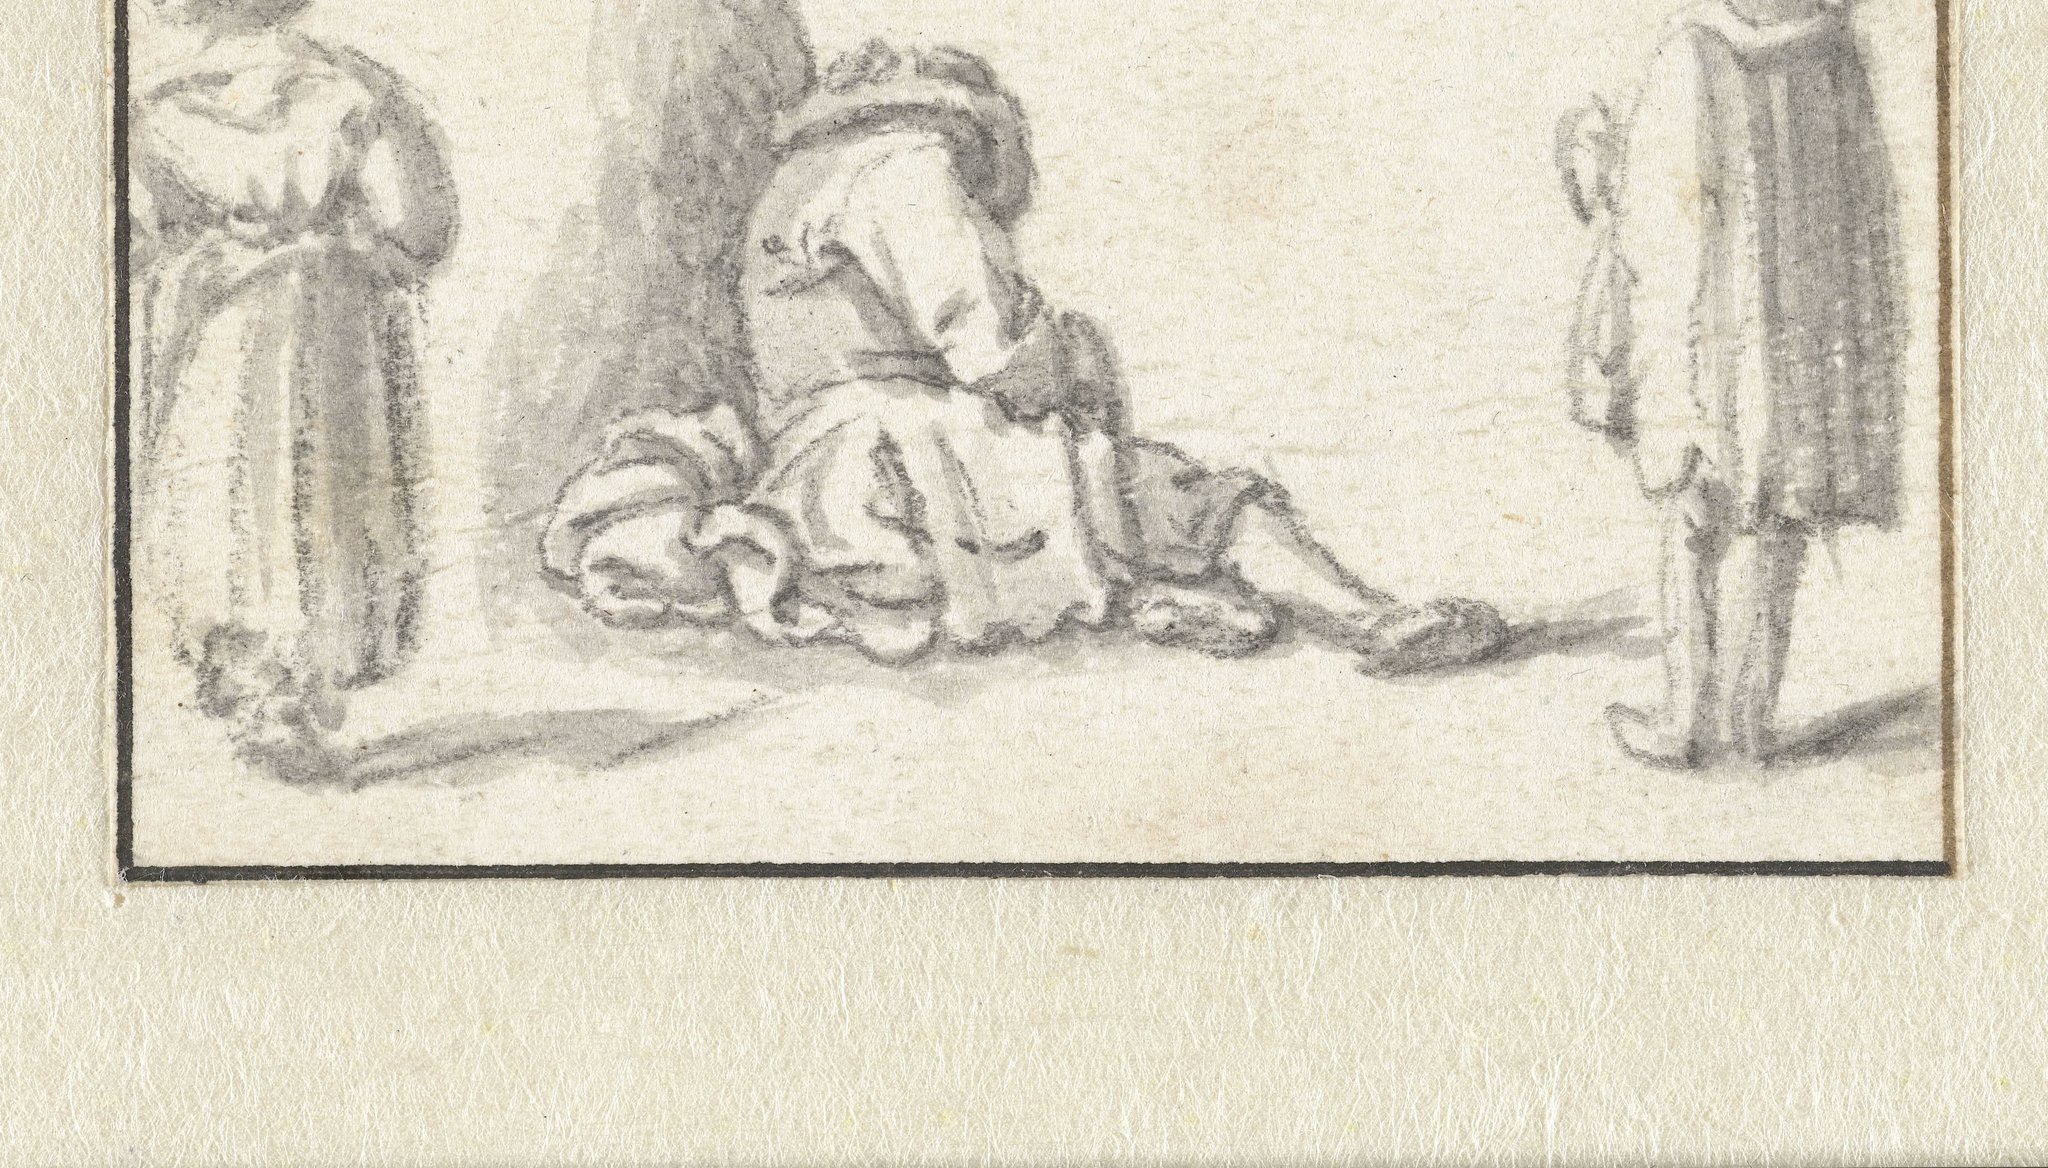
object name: drawing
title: Slapende man, een staande vrouw en een staande man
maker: herman saftleven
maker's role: draughtsman, painter, print maker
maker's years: 1609-1685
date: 1619-1685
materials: chalk, paper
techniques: brush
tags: standing figure, sleeping on the ground, standing figure - aa - female human figure, lying on the back with uplifted upper part of the body